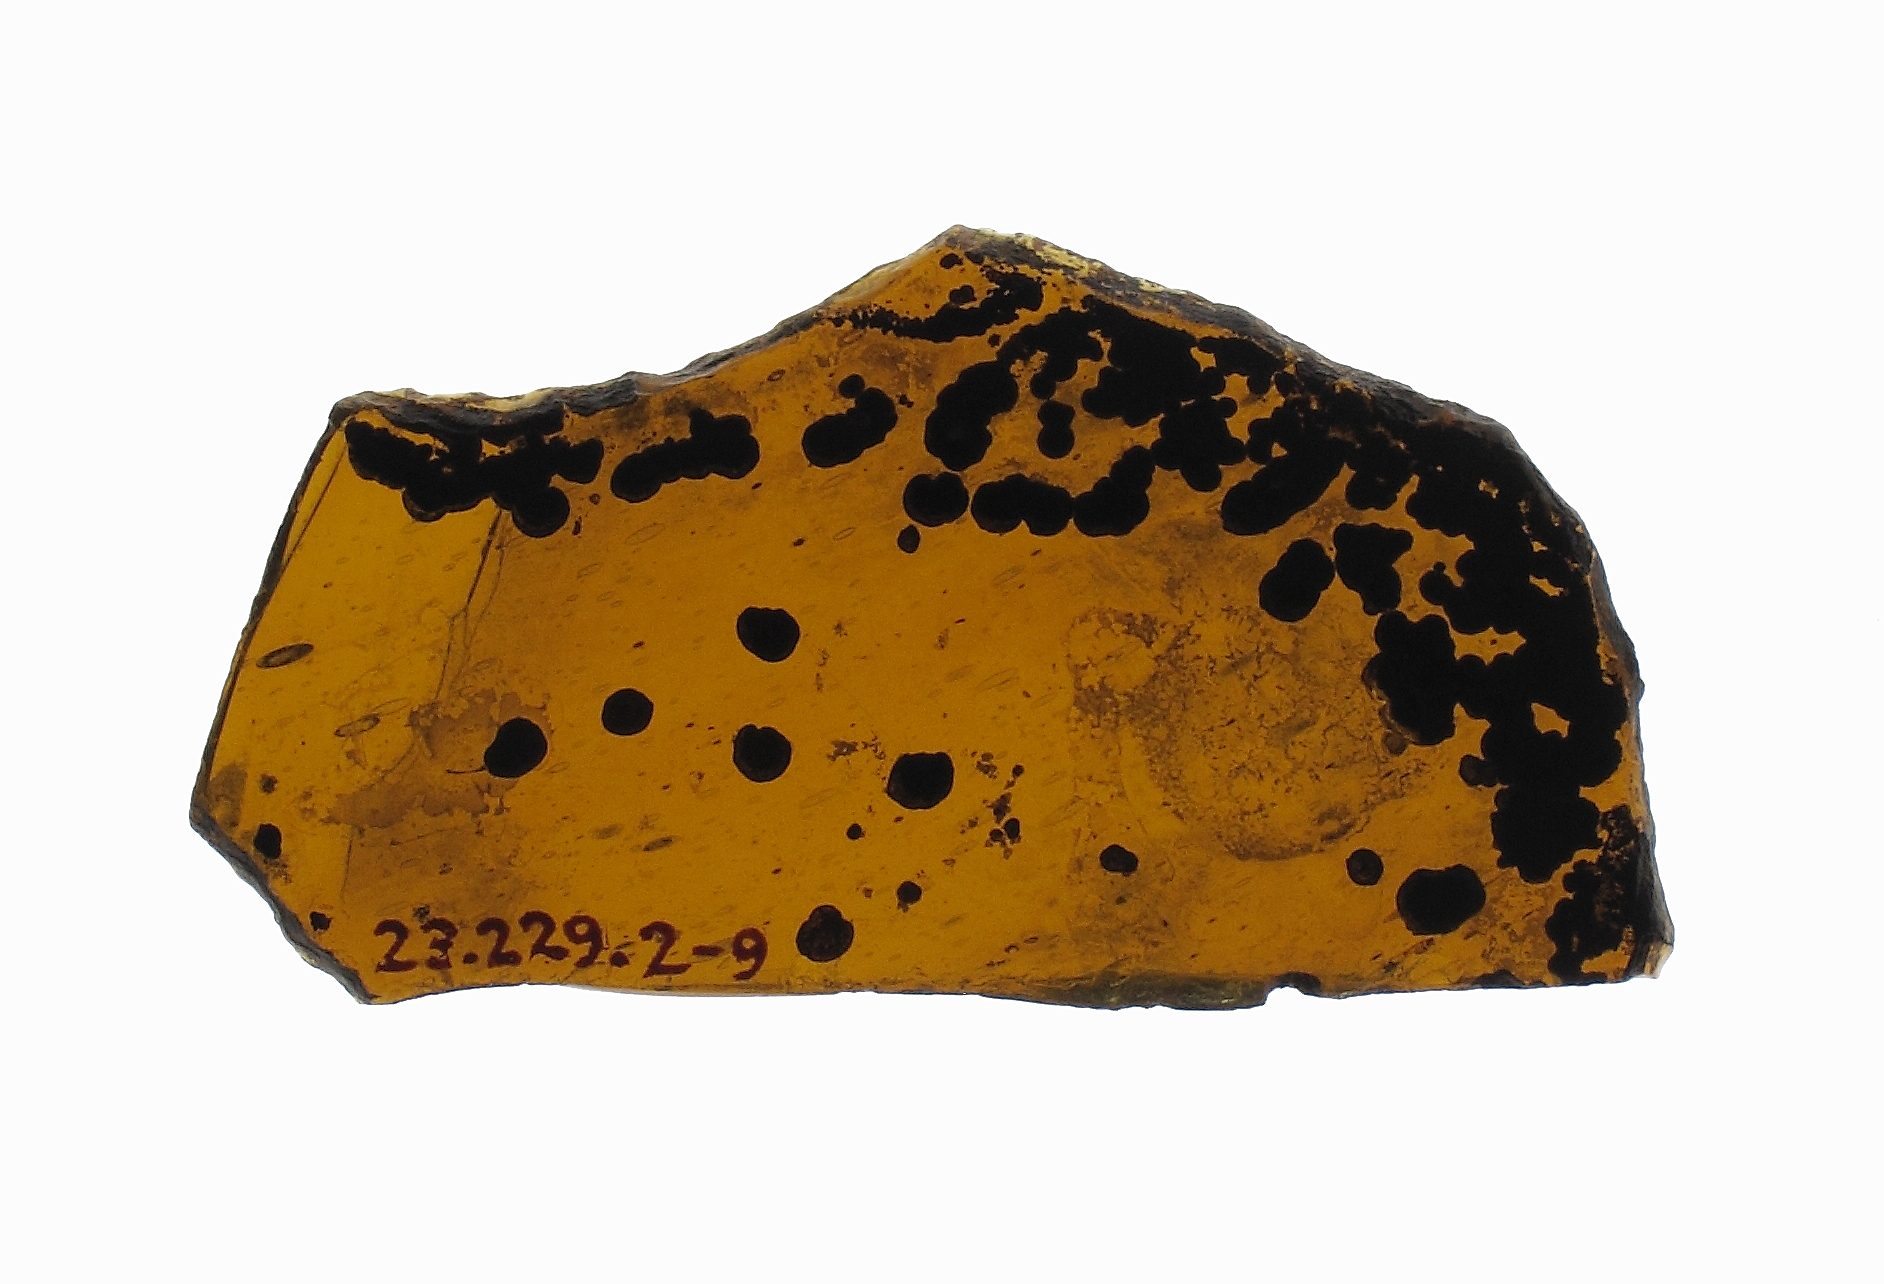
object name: fragment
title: Glass Fragment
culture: french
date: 1101-1200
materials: glass, metal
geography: france